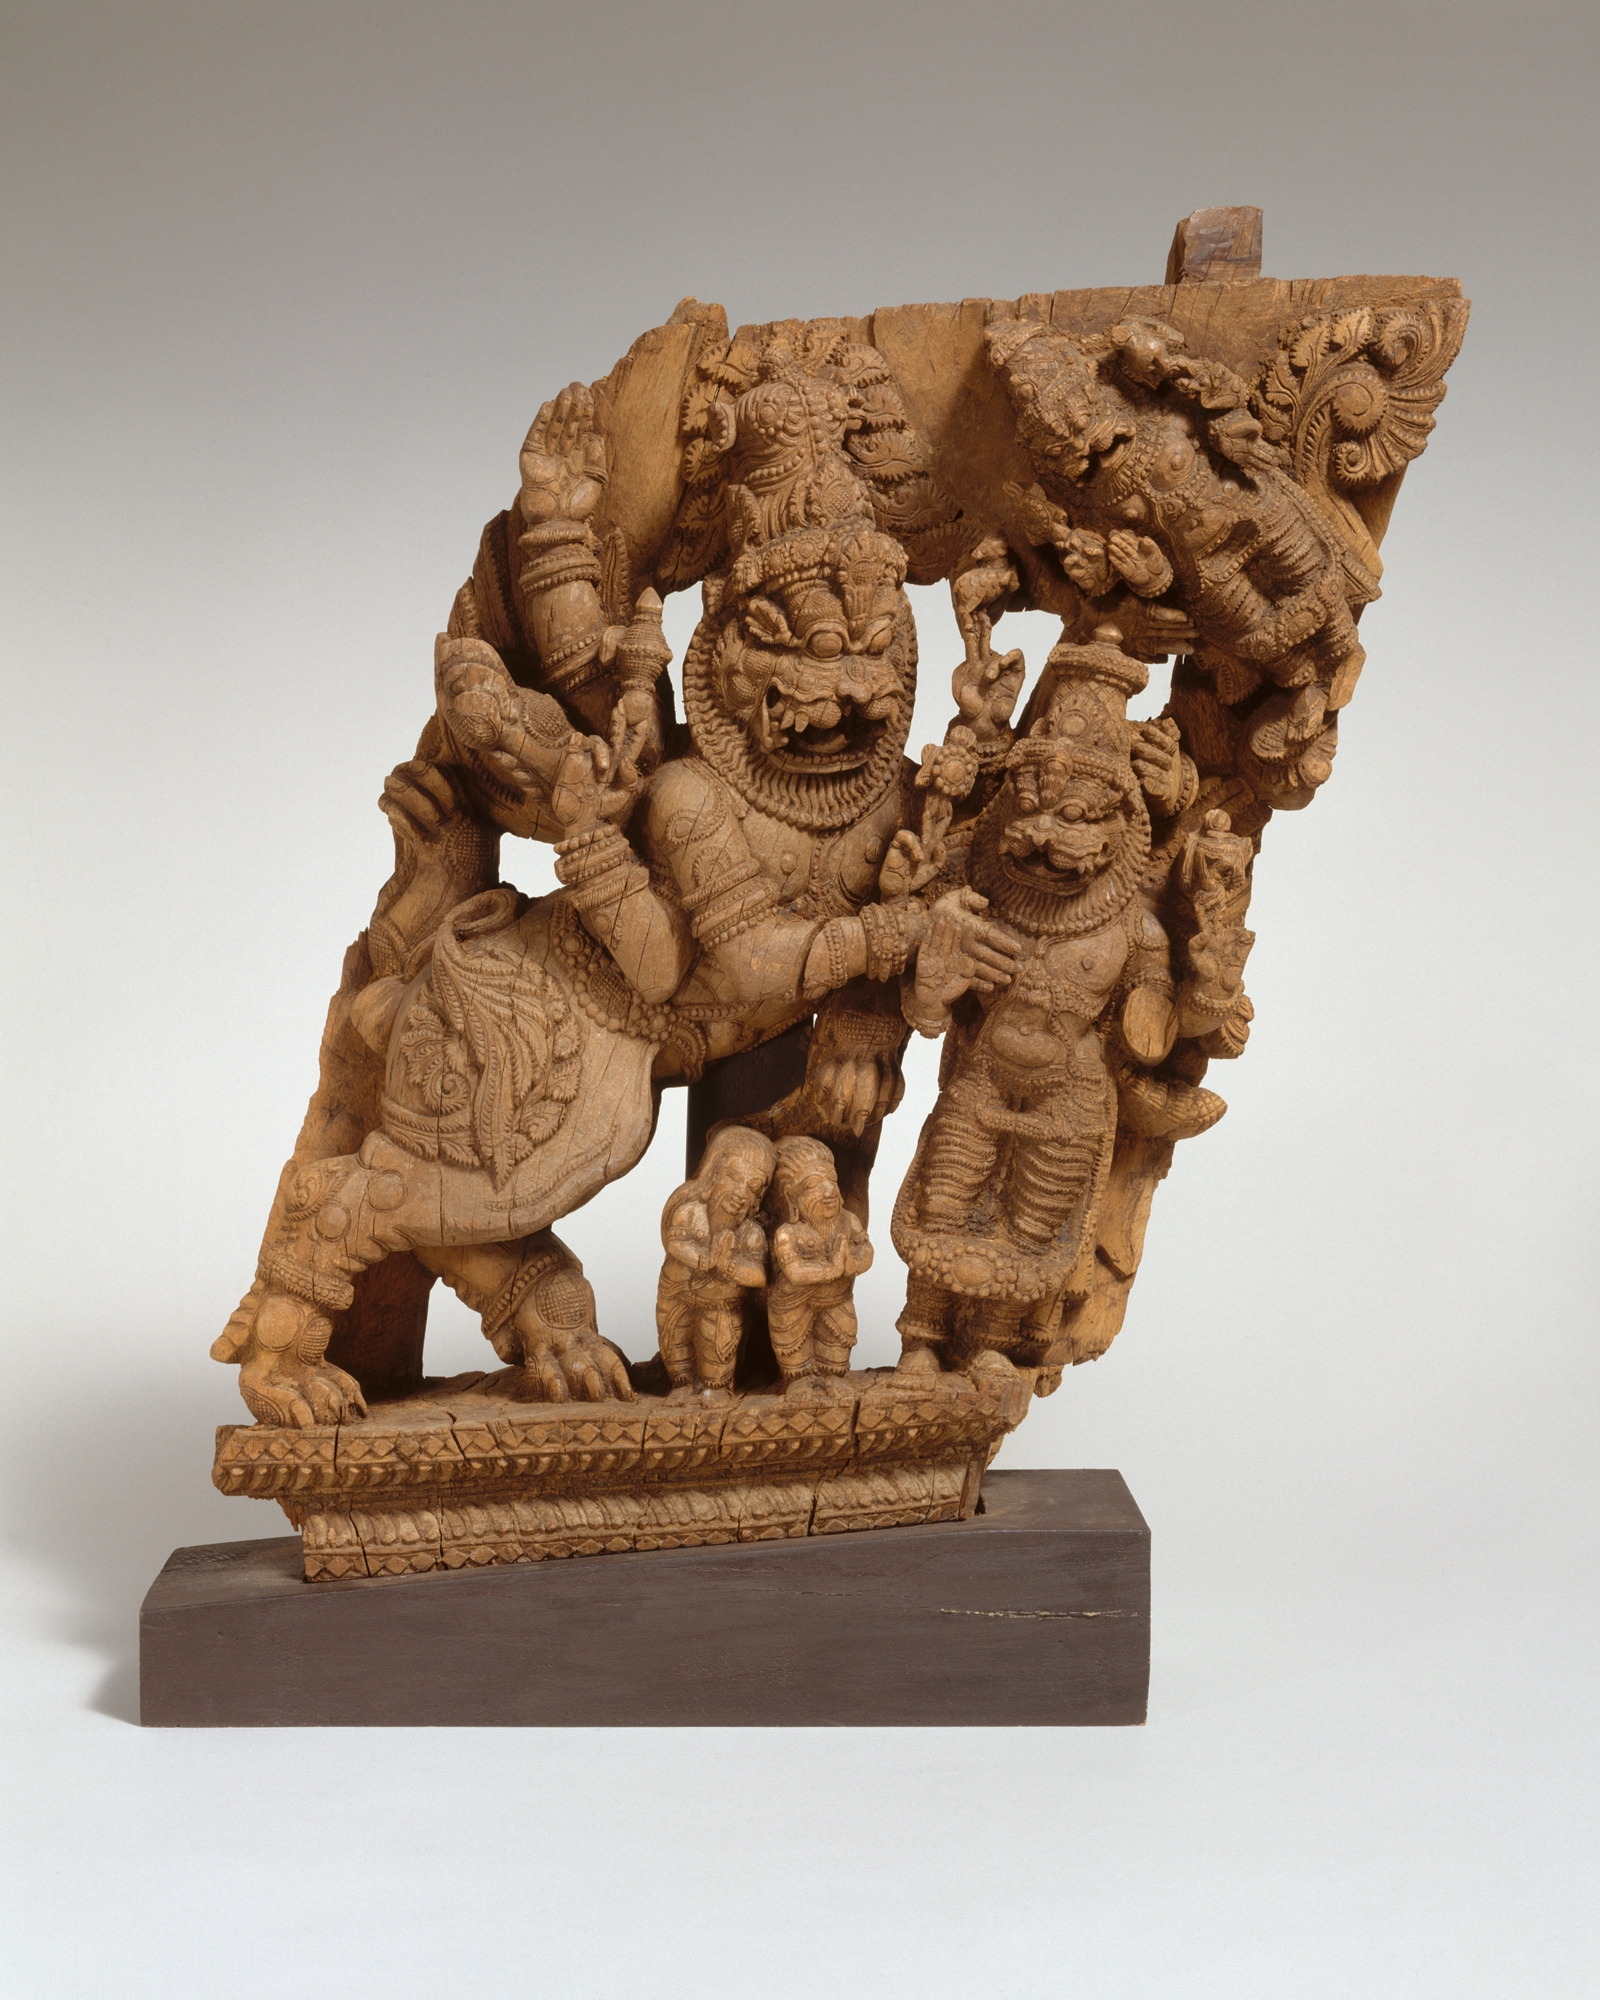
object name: relief panel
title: Panel from a Ritual Chariot: Narasimha, the Man-Lion Incarnation of Vishnu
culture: tamil nadu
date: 1601-1800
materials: wood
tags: mythical creatures,hinduism